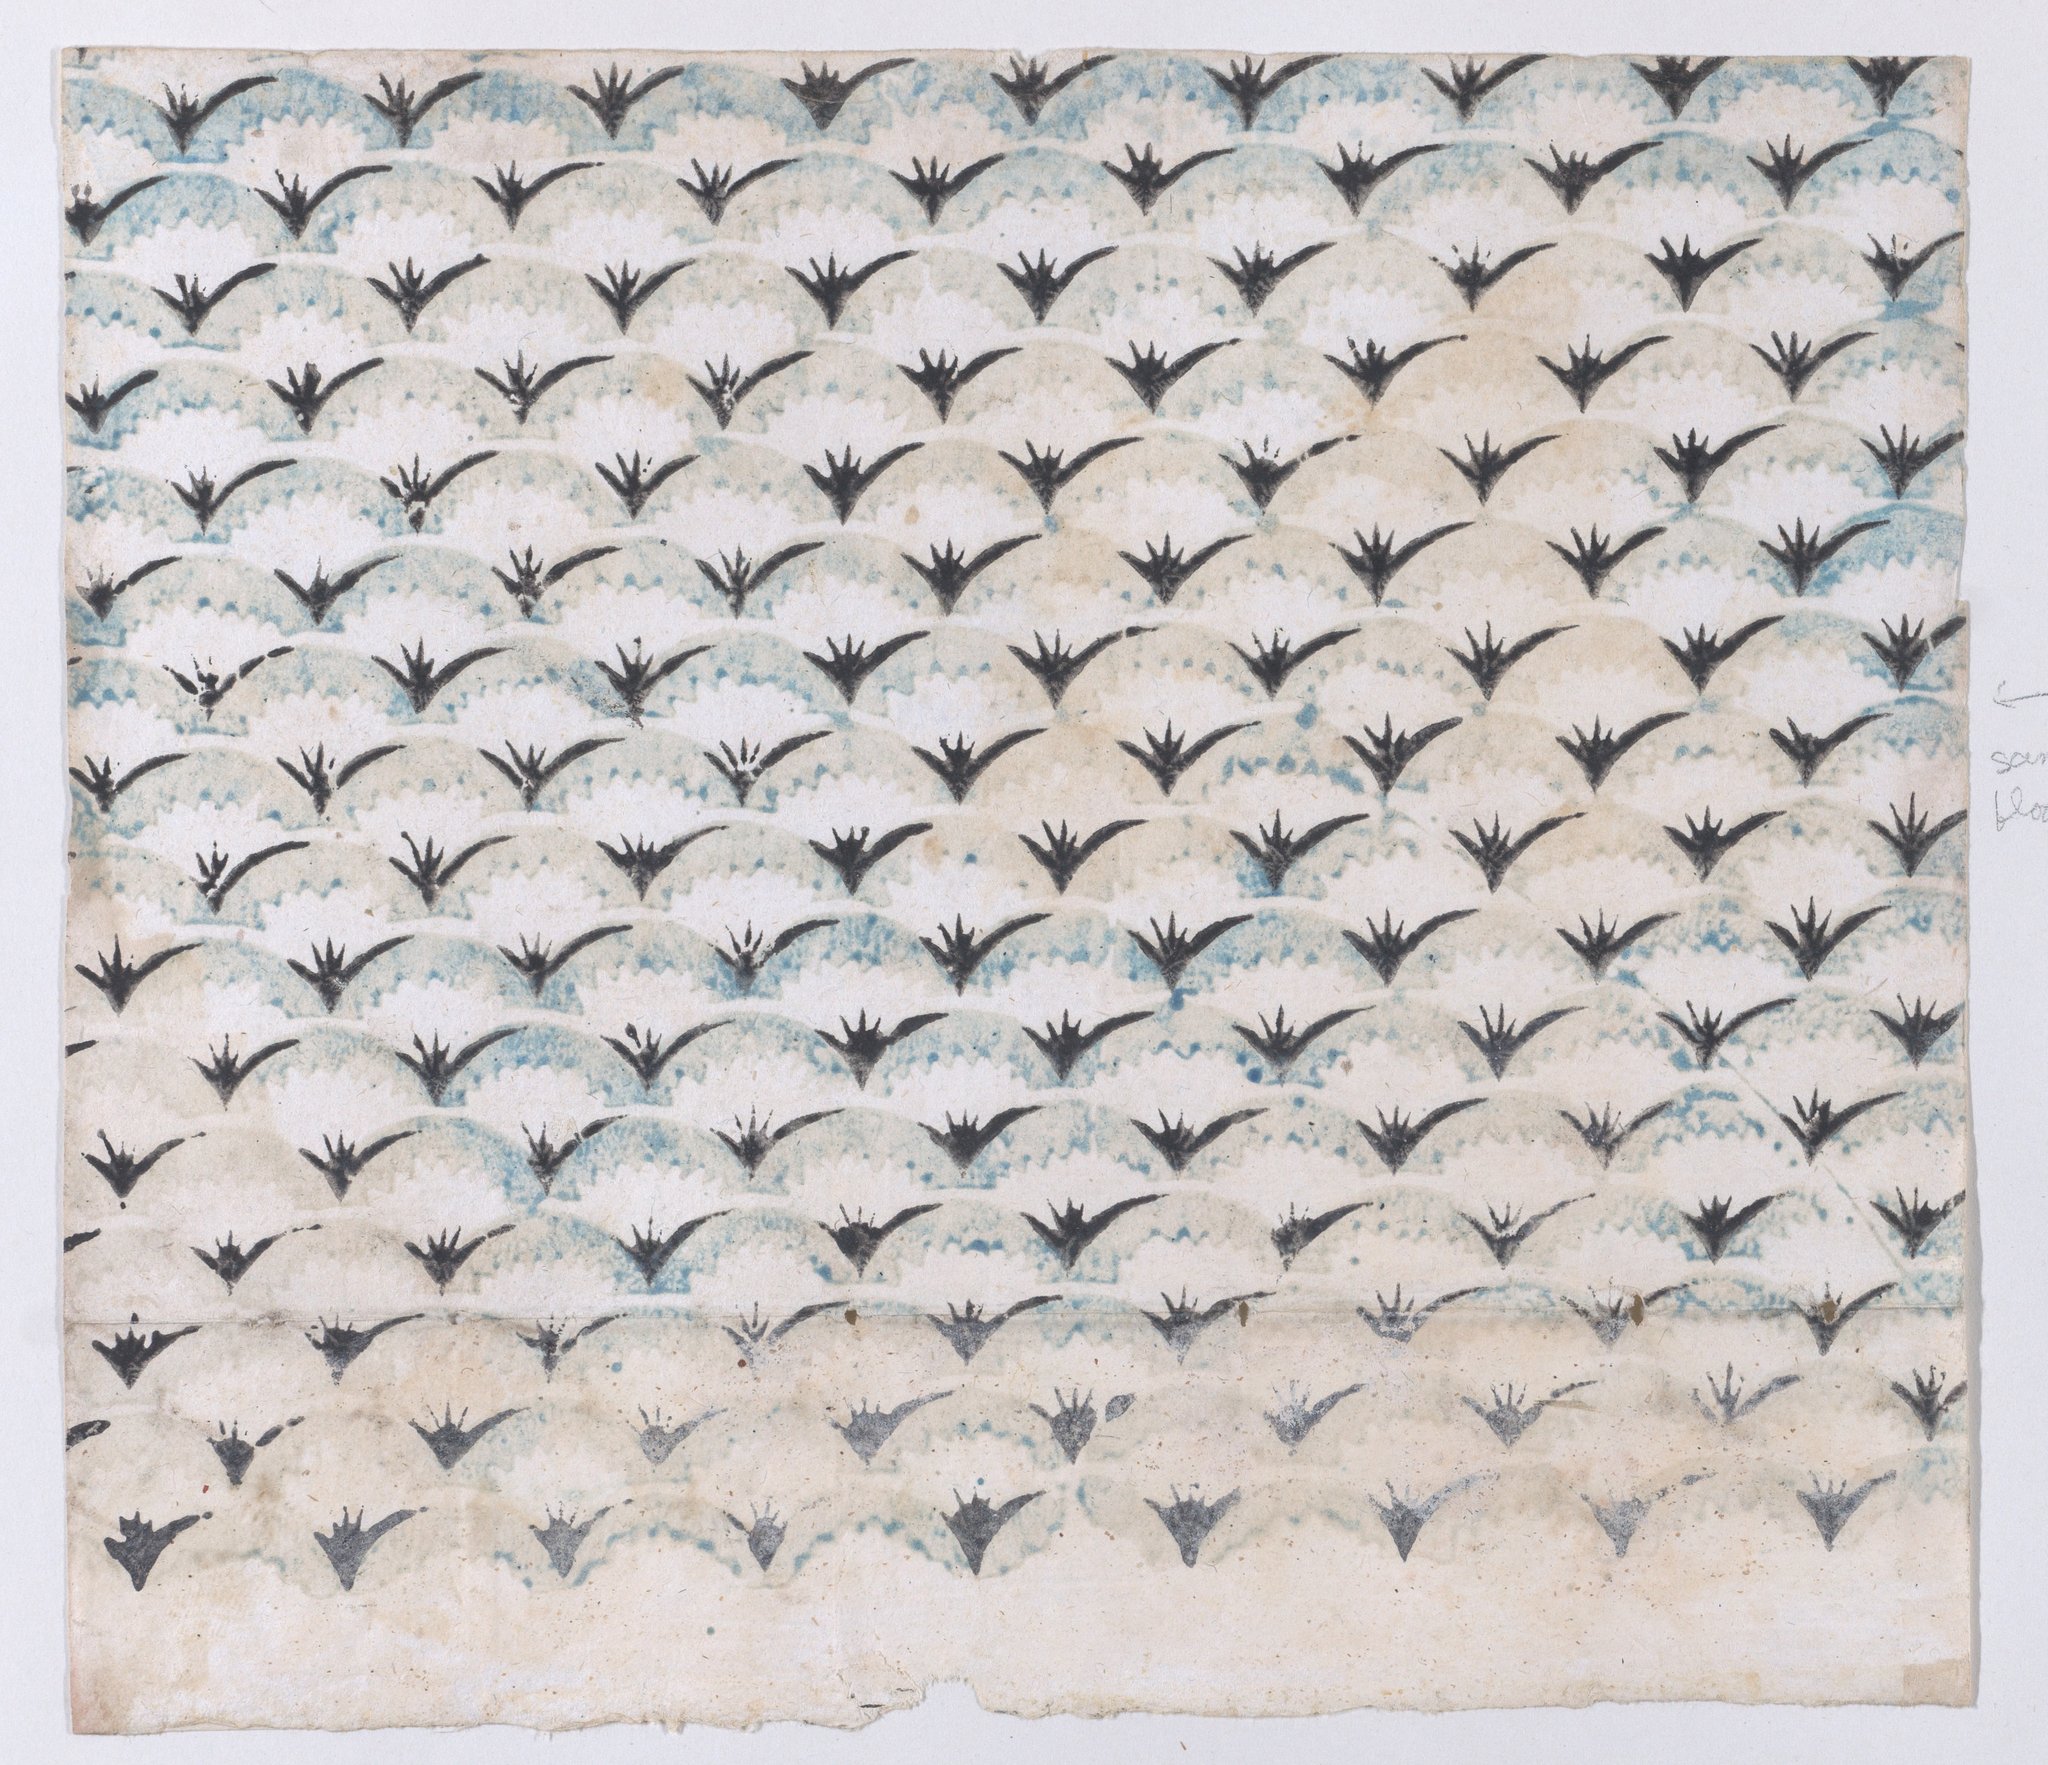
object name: print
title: Sheet with overall curved abstract pattern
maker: Anonymous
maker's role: artist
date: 1801-1900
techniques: relief print